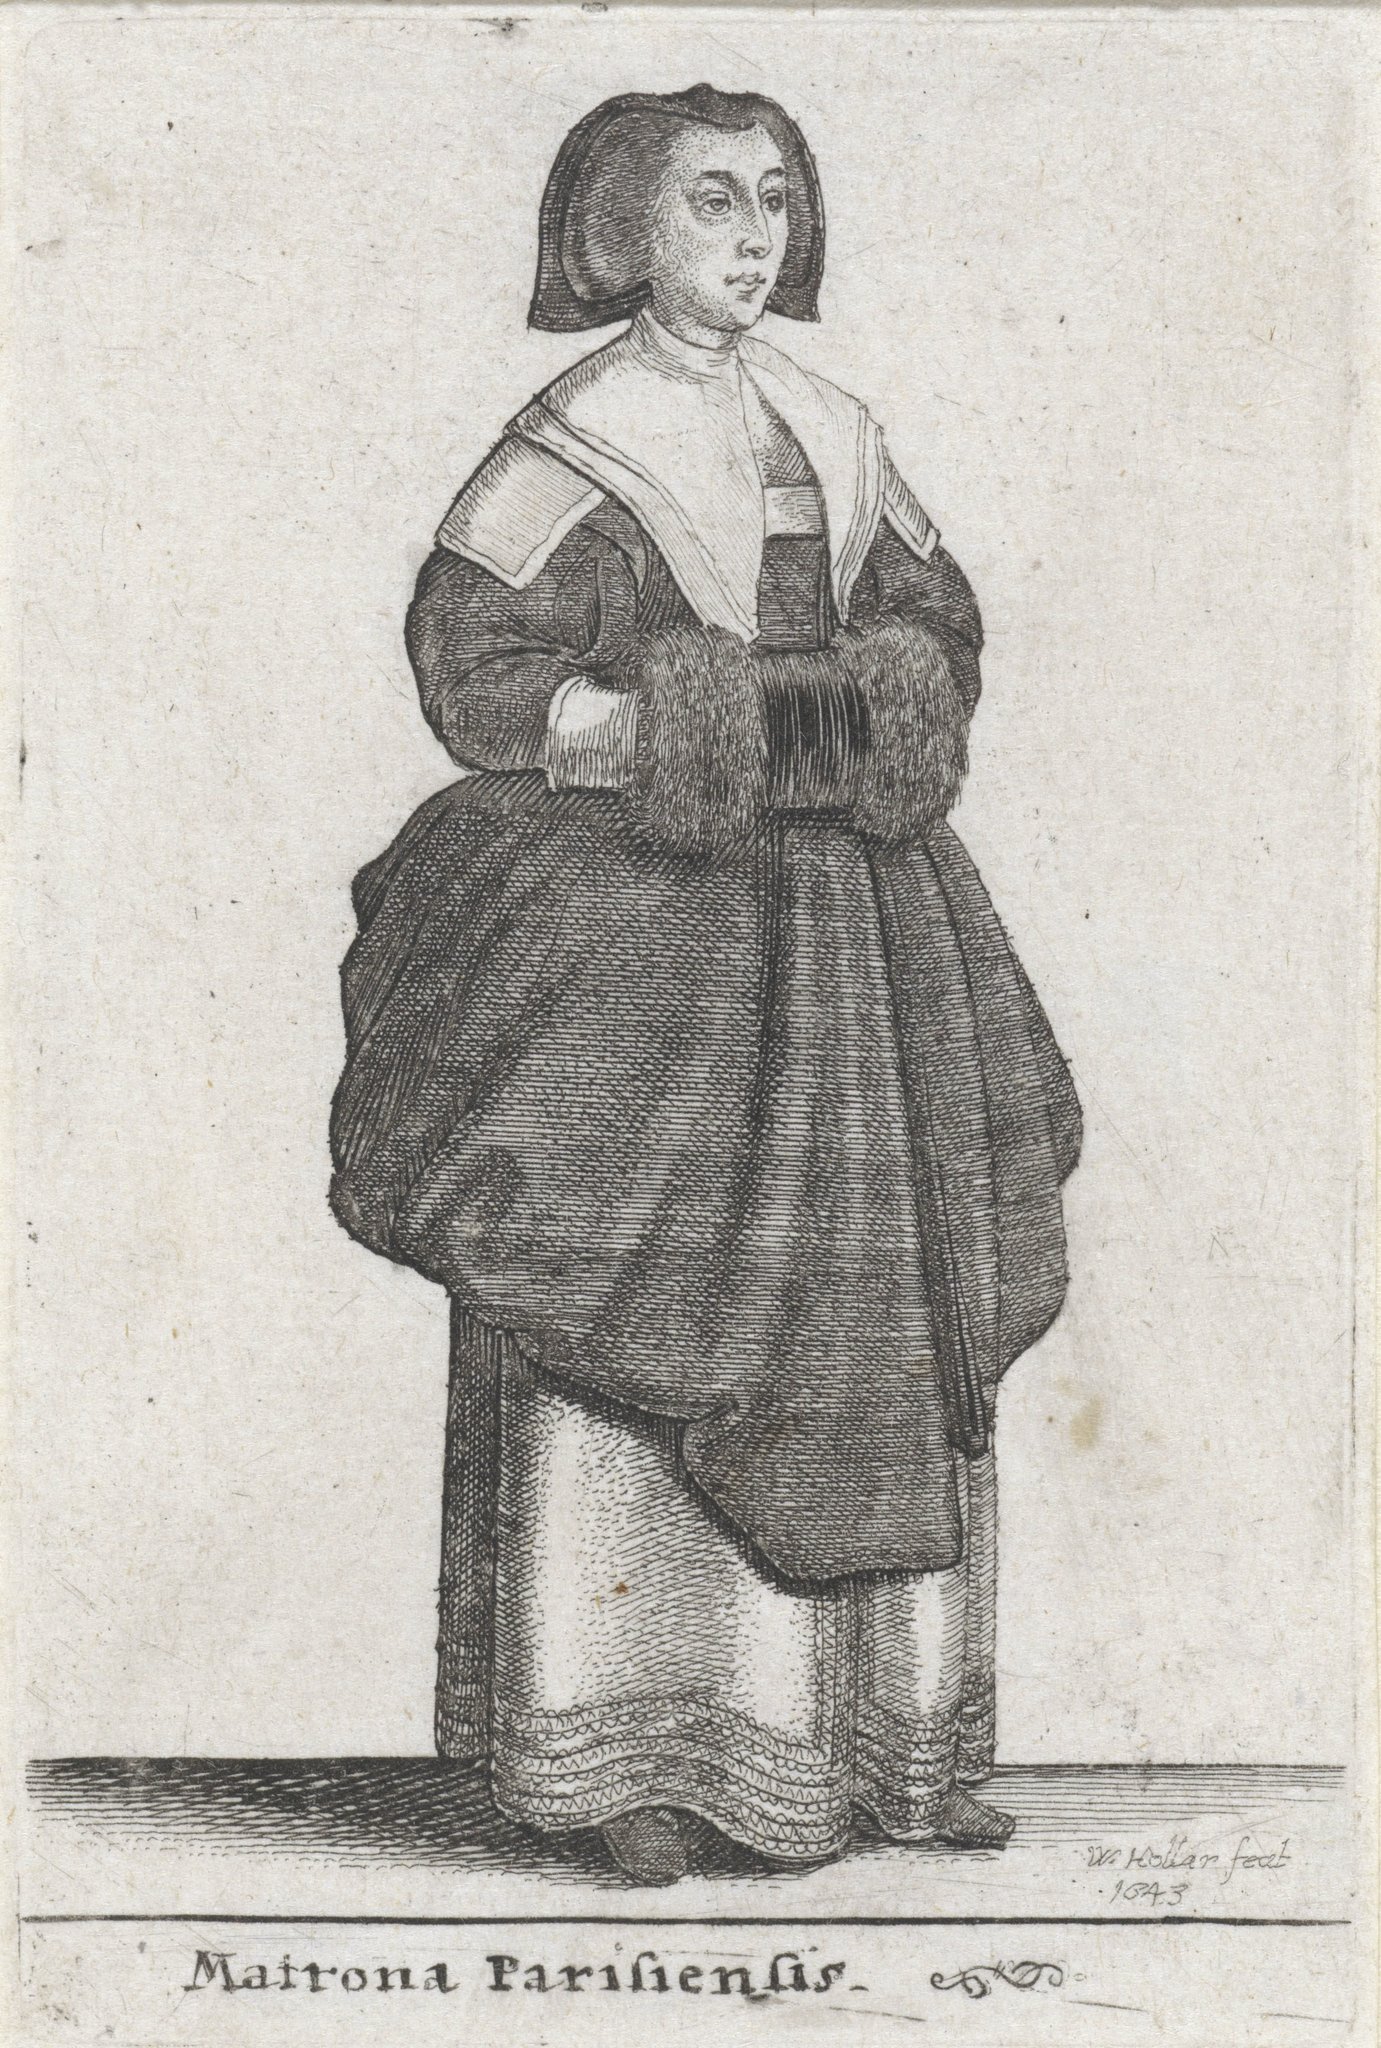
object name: costume print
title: Theatrum Mulierum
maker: wenceslaus hollar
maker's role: draughtsman, print maker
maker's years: 1607-1677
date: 1643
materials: paper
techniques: etching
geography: london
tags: paris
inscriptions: collector's mark: Lugt 240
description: Een getrouwde vrouw uit Parijs, half naar rechts gekeerd, een zwarte kap op het hoofd. Hoog gesloten kraag met lange punten over de schouders. Het overkleed is van achteren opgeschort zodat het onderkleed met versierde zoom is te zien. De beide handen in een mof van bont.